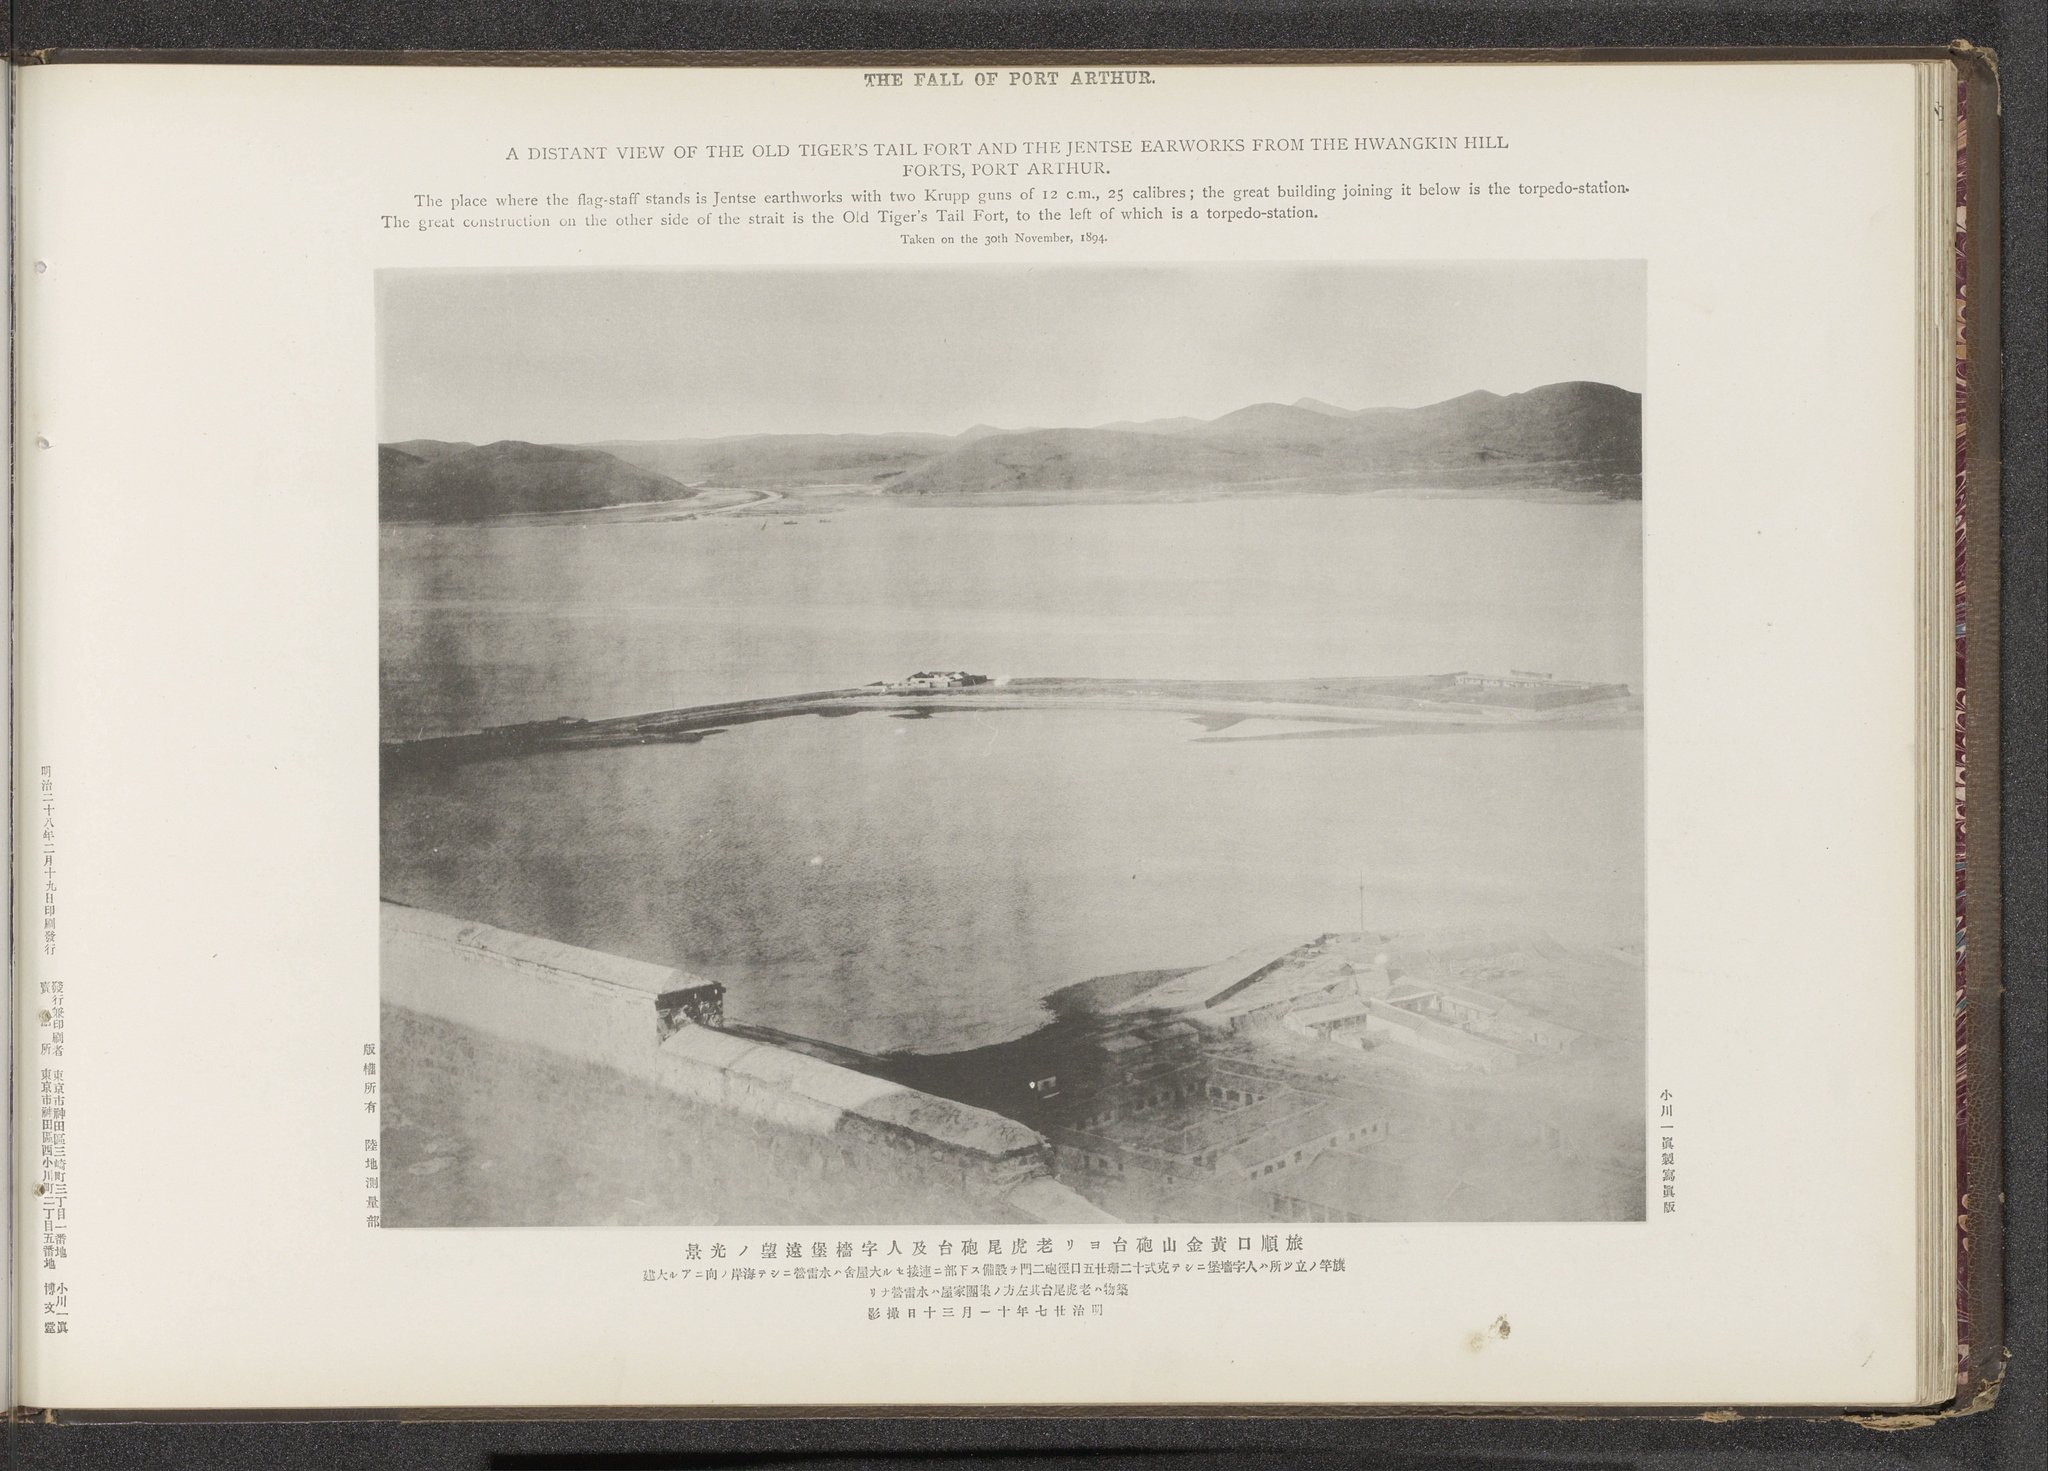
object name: page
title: A distant view of the Old tiger's tail fort and the Jentse earworks from the Hwangkin hill forts, Port Arthur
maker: kazumasa ogawa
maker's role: auteur, fotograaf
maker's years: 1860-1929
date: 1894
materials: paper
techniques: photograph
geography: manchuria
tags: straits, narrows, fortress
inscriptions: inscription: ‘The place where the flag-staff stands is Jentse (...) to the left of which is a torpedo-station.’, inscription: ‘The fall of Port Arthur.’